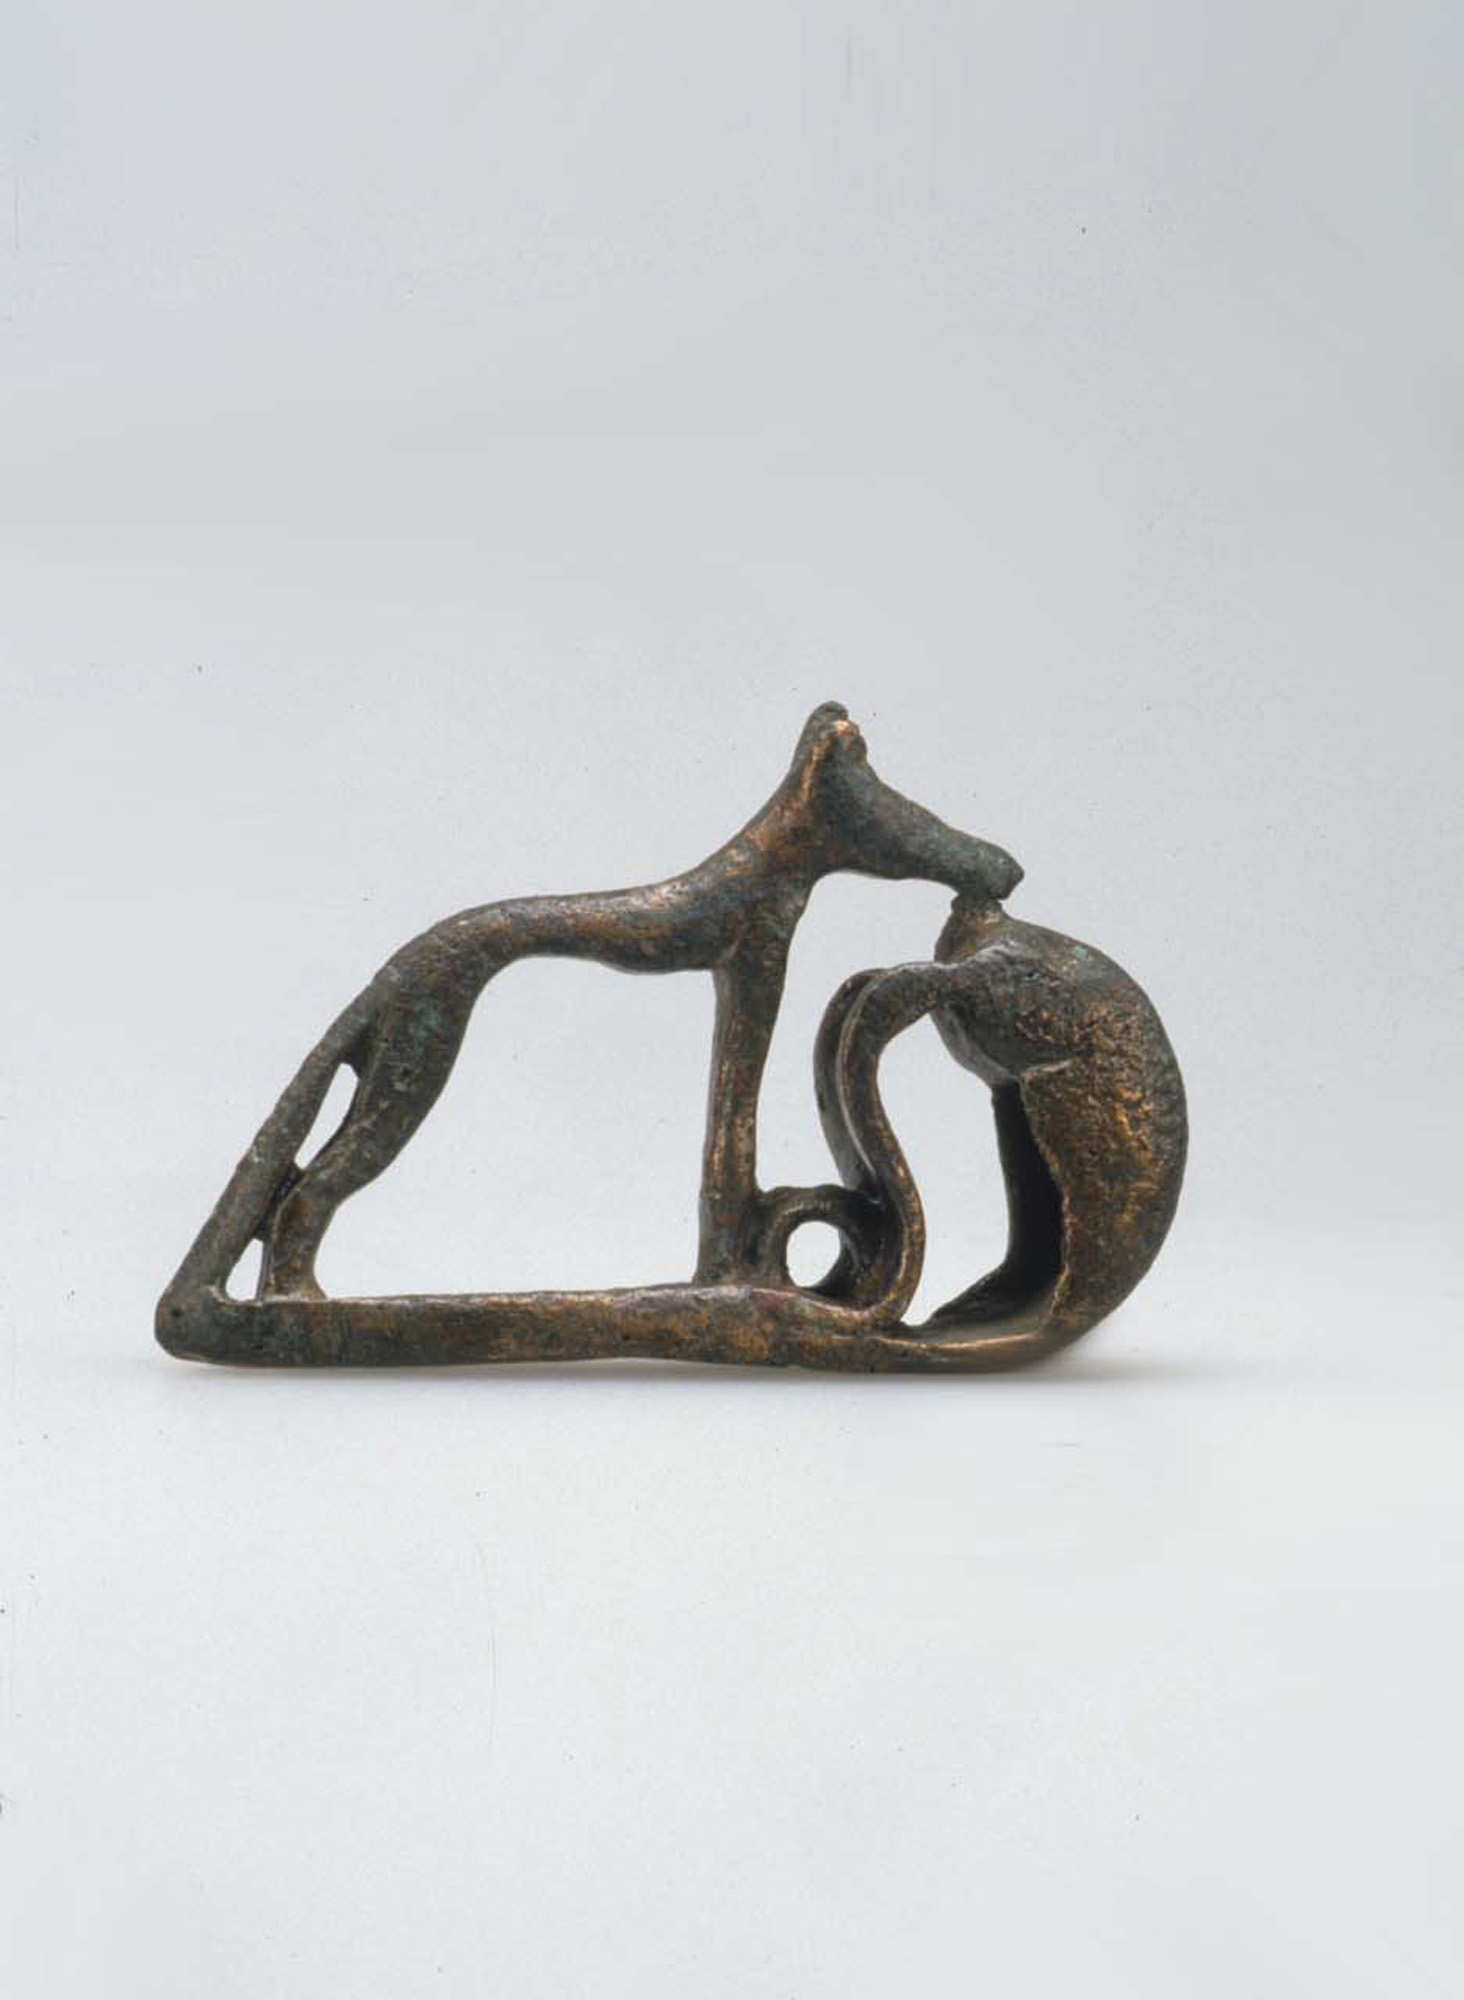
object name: figurine, jackal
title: Jackal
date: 664-630 BCE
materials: metal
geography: egypt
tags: jackals